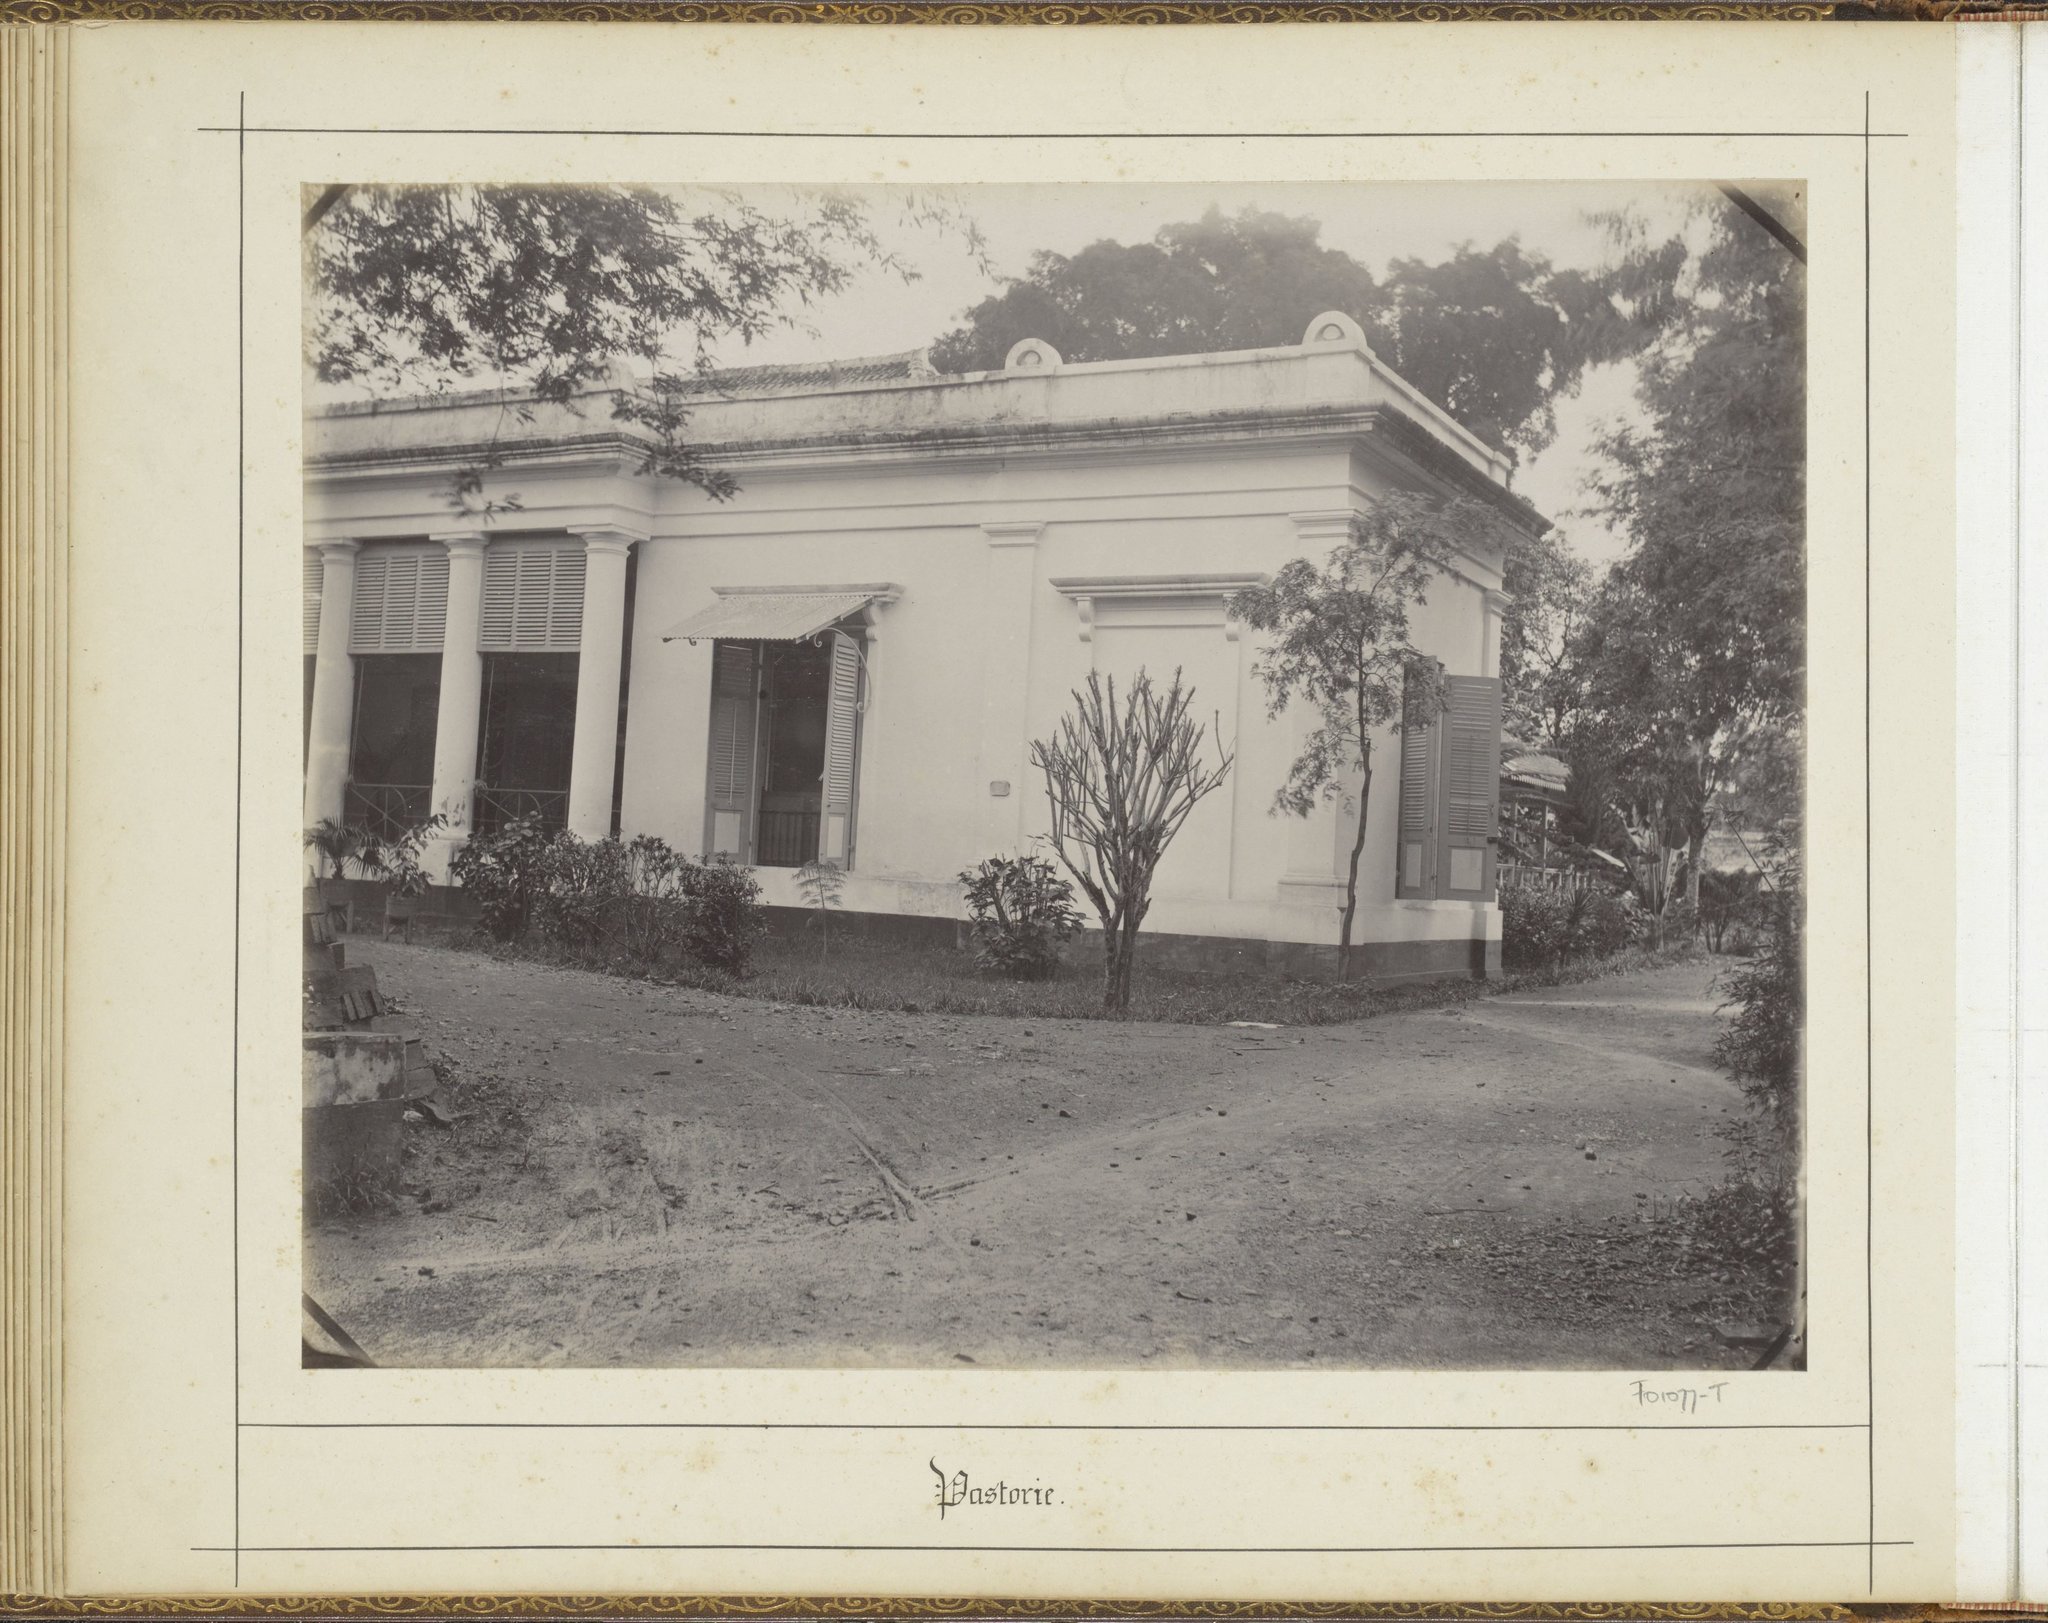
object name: photograph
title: Exterieur van de pastorie van de rooms-katholieke kerk in Batavia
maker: Anonymous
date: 1890-1910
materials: paper, photographic support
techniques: albumen print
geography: batavia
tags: exterior ~ representation of a building, batavia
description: Onderdeel van Album met foto's van Batavia en van de zusters Ursulinen.